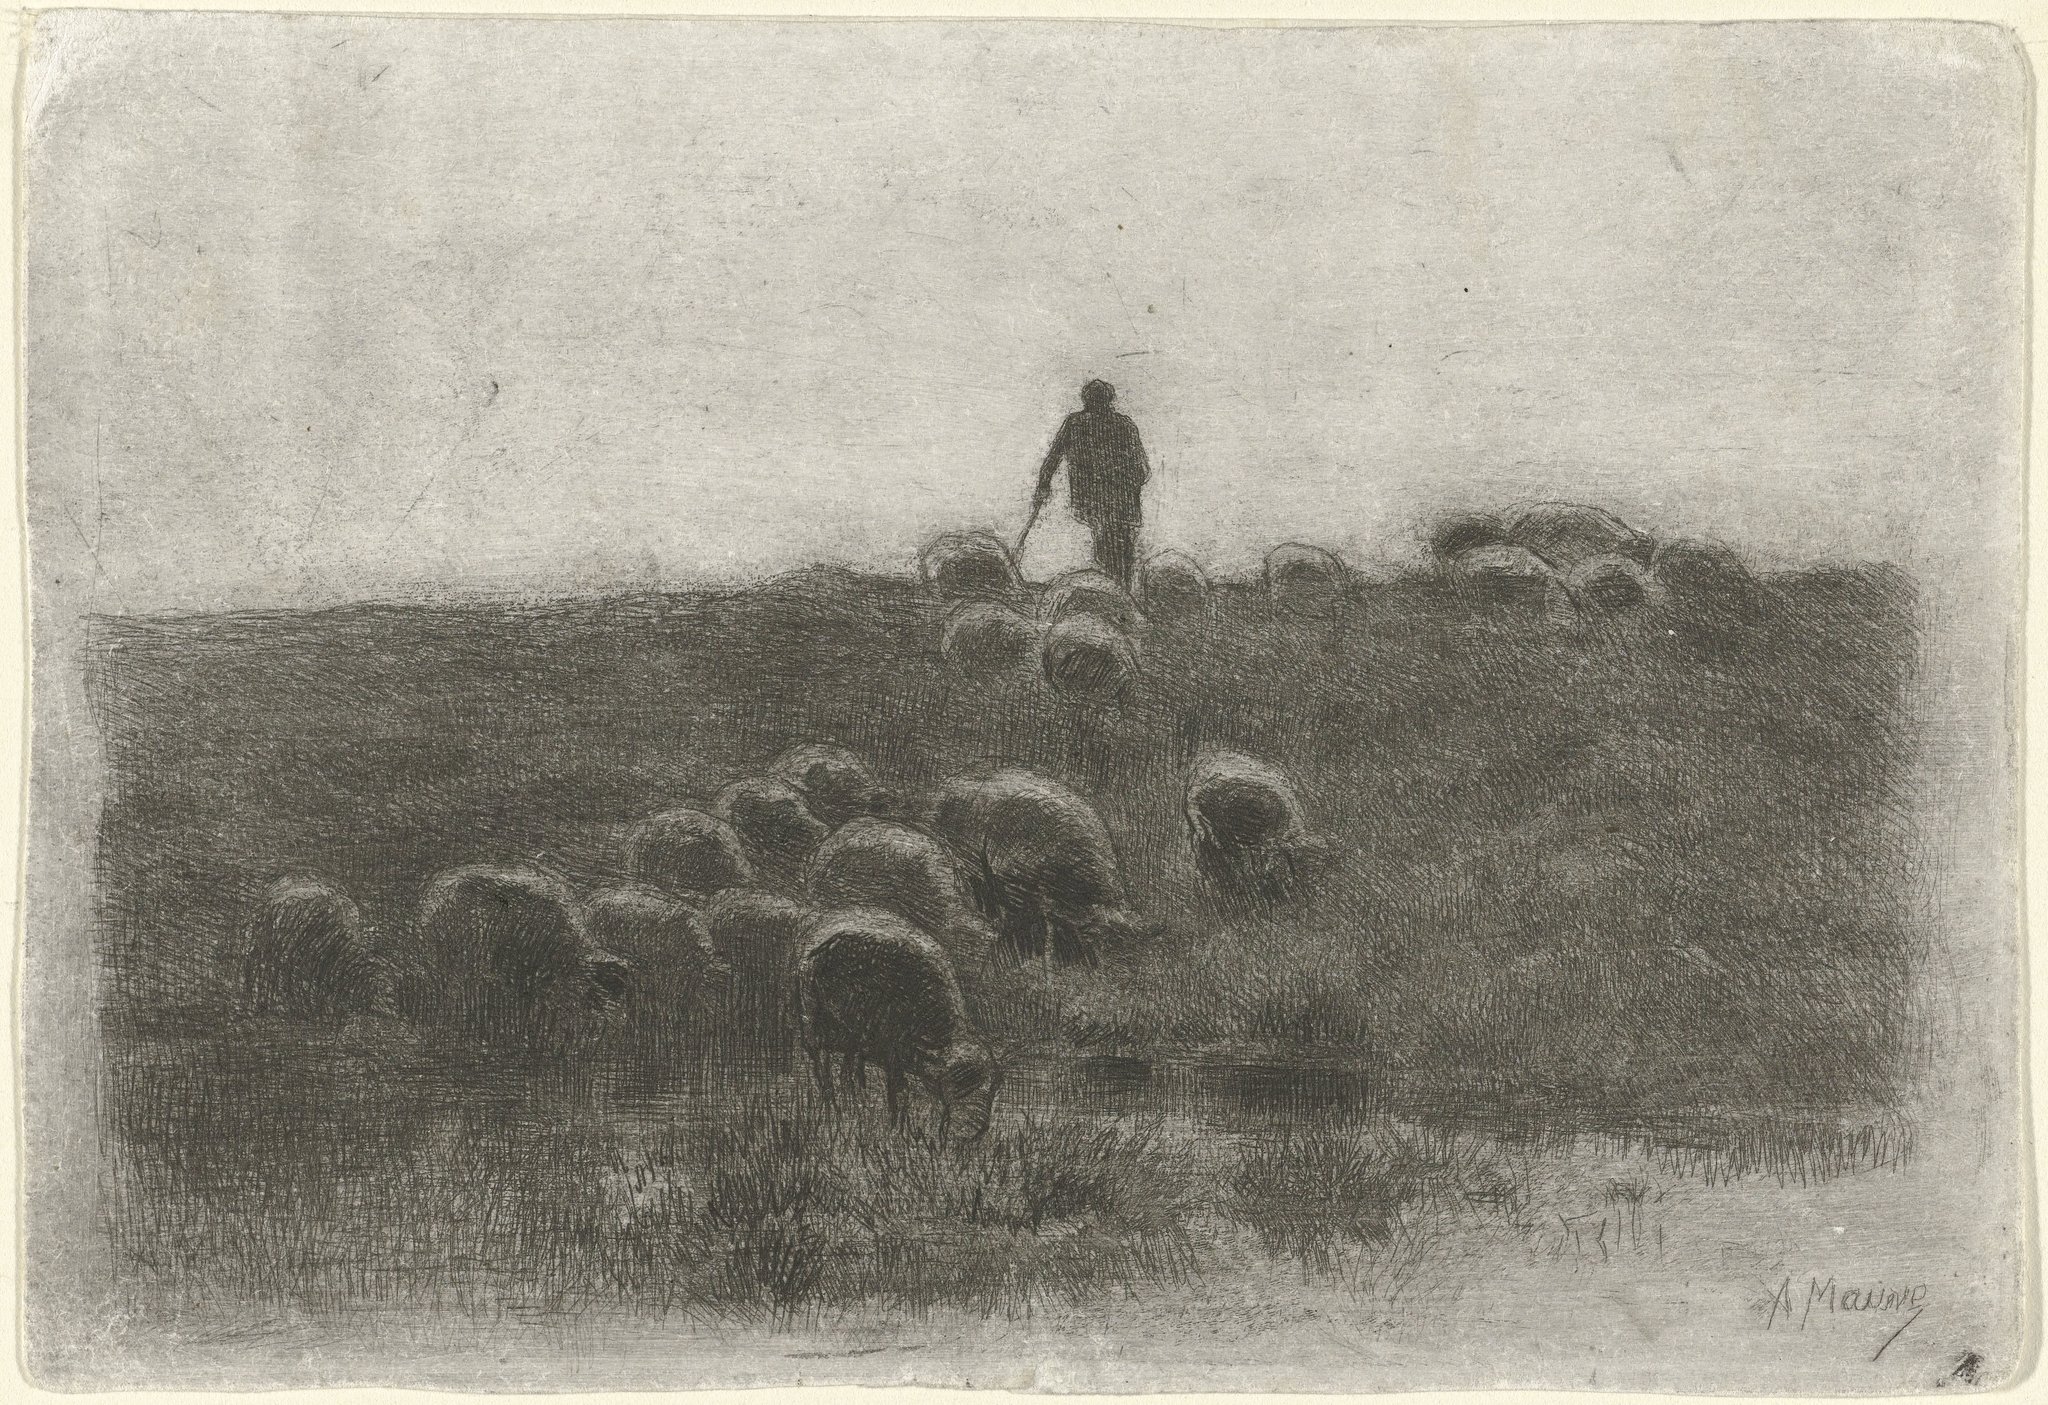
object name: print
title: Herder met kudde schapen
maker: anton mauve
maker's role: draughtsman, painter, print maker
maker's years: 1838-1888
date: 1848-1888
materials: paper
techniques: etching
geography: netherlands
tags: herding, herdsman, herdswoman, shepherd, shepherdess, cowherd, etc., sheep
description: Schapen en op de achtergrond het silhouet van een herder, leunend op een stok.